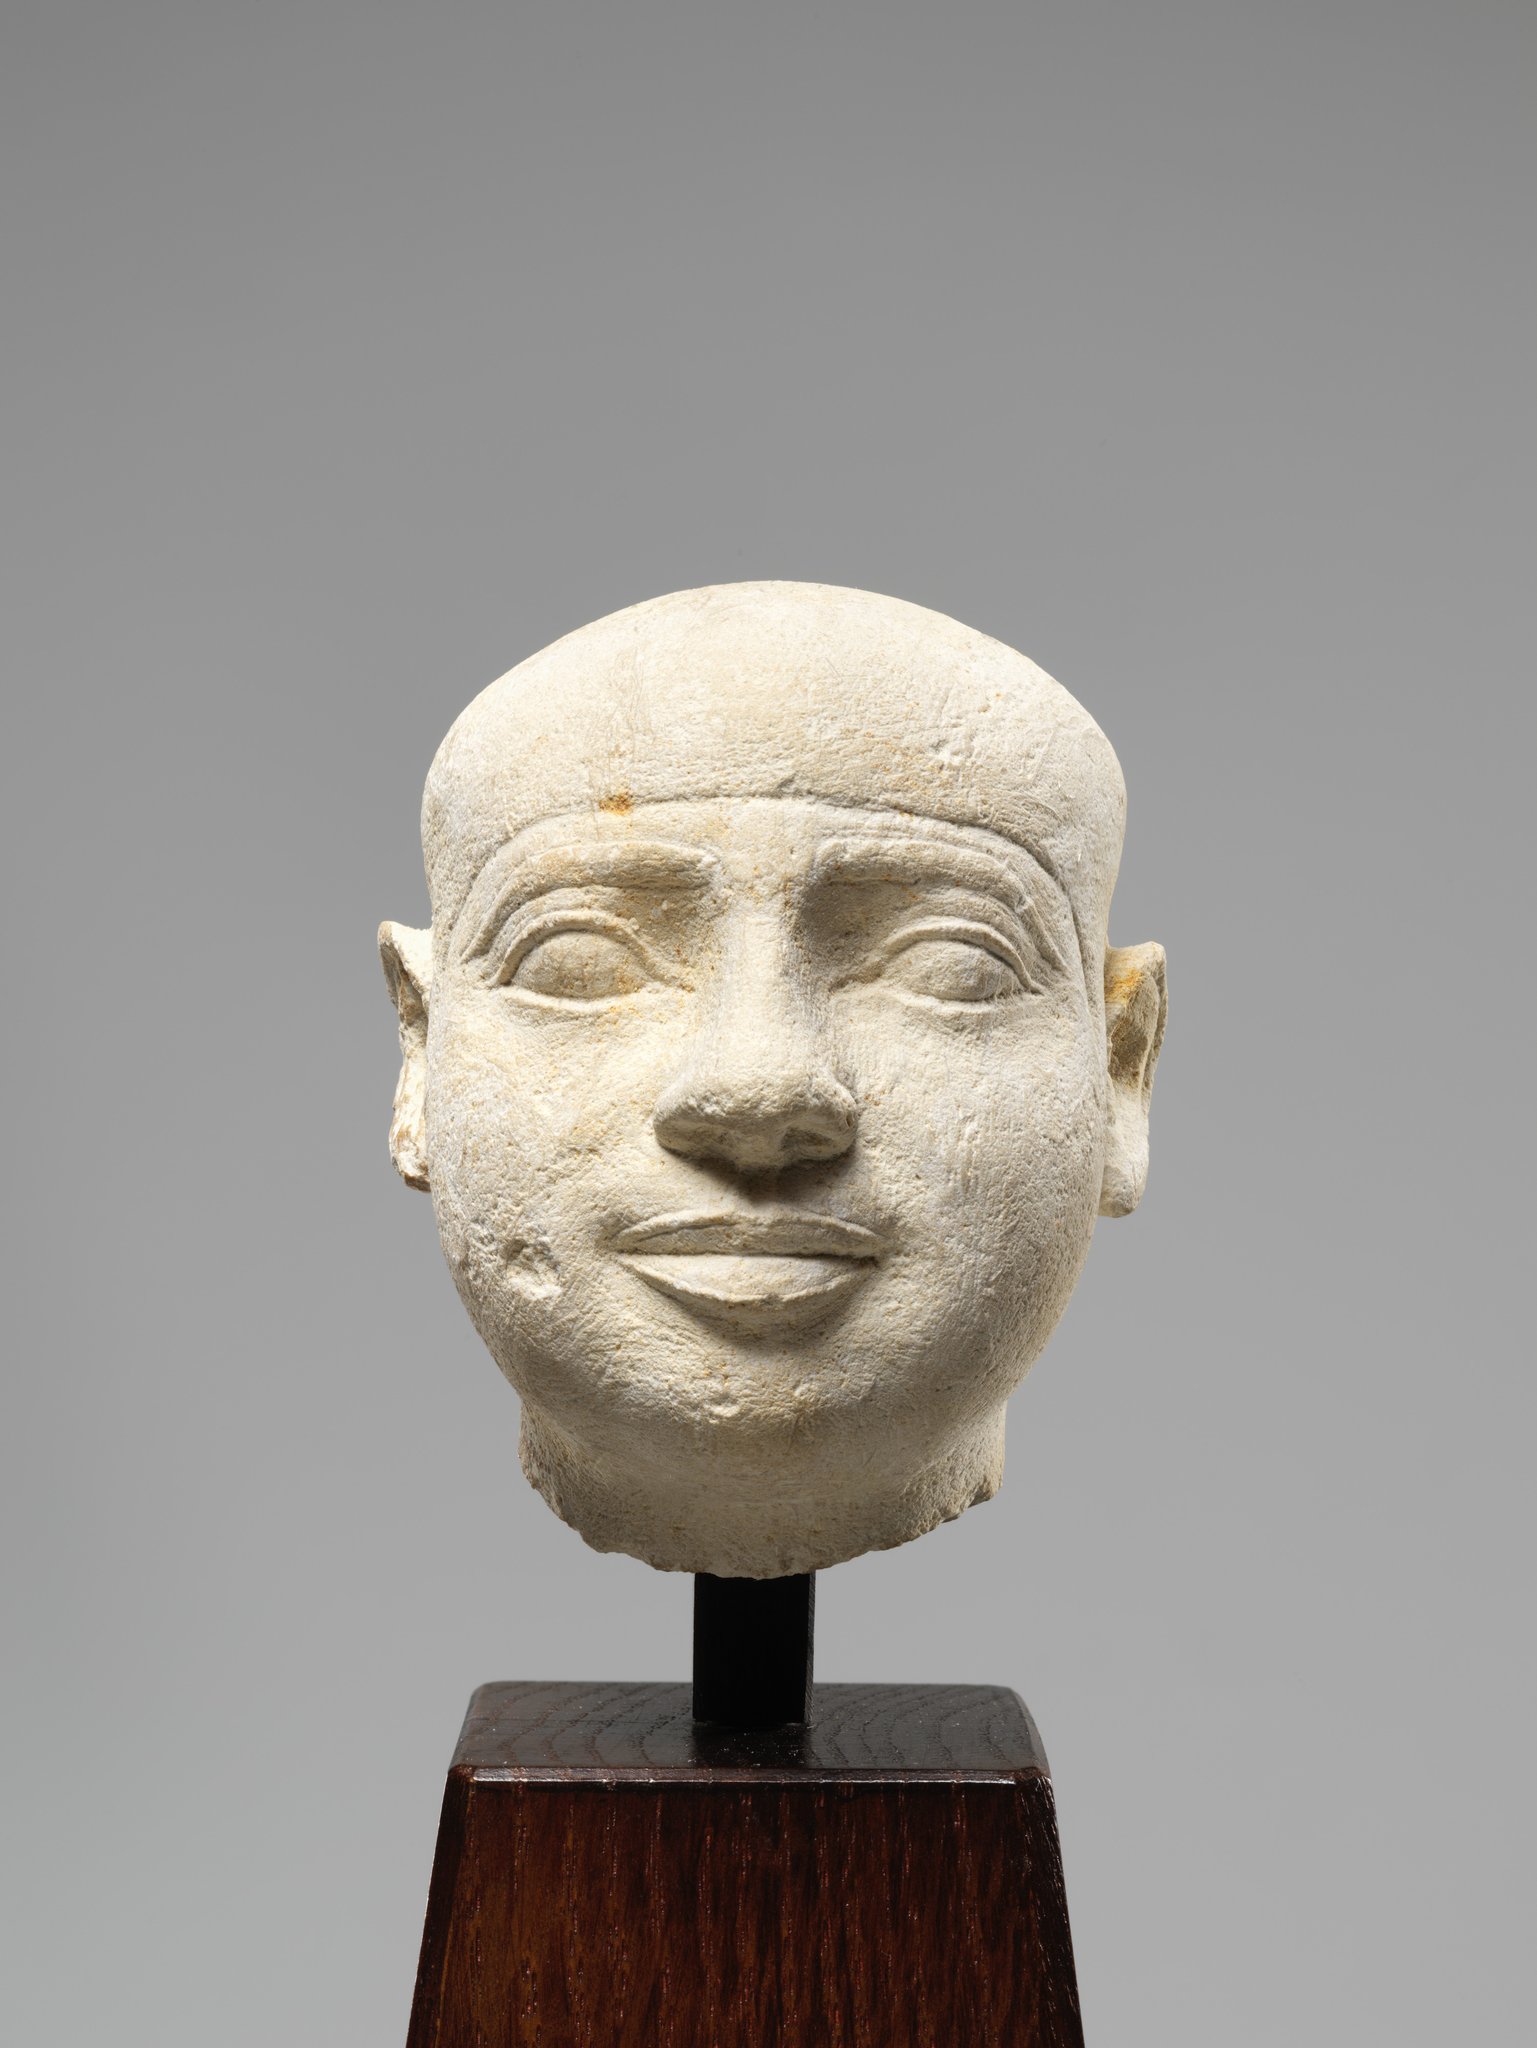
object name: head, male statue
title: Male Head, Probably from a Serving Statue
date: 2465-2323 BCE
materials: limestone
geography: egypt